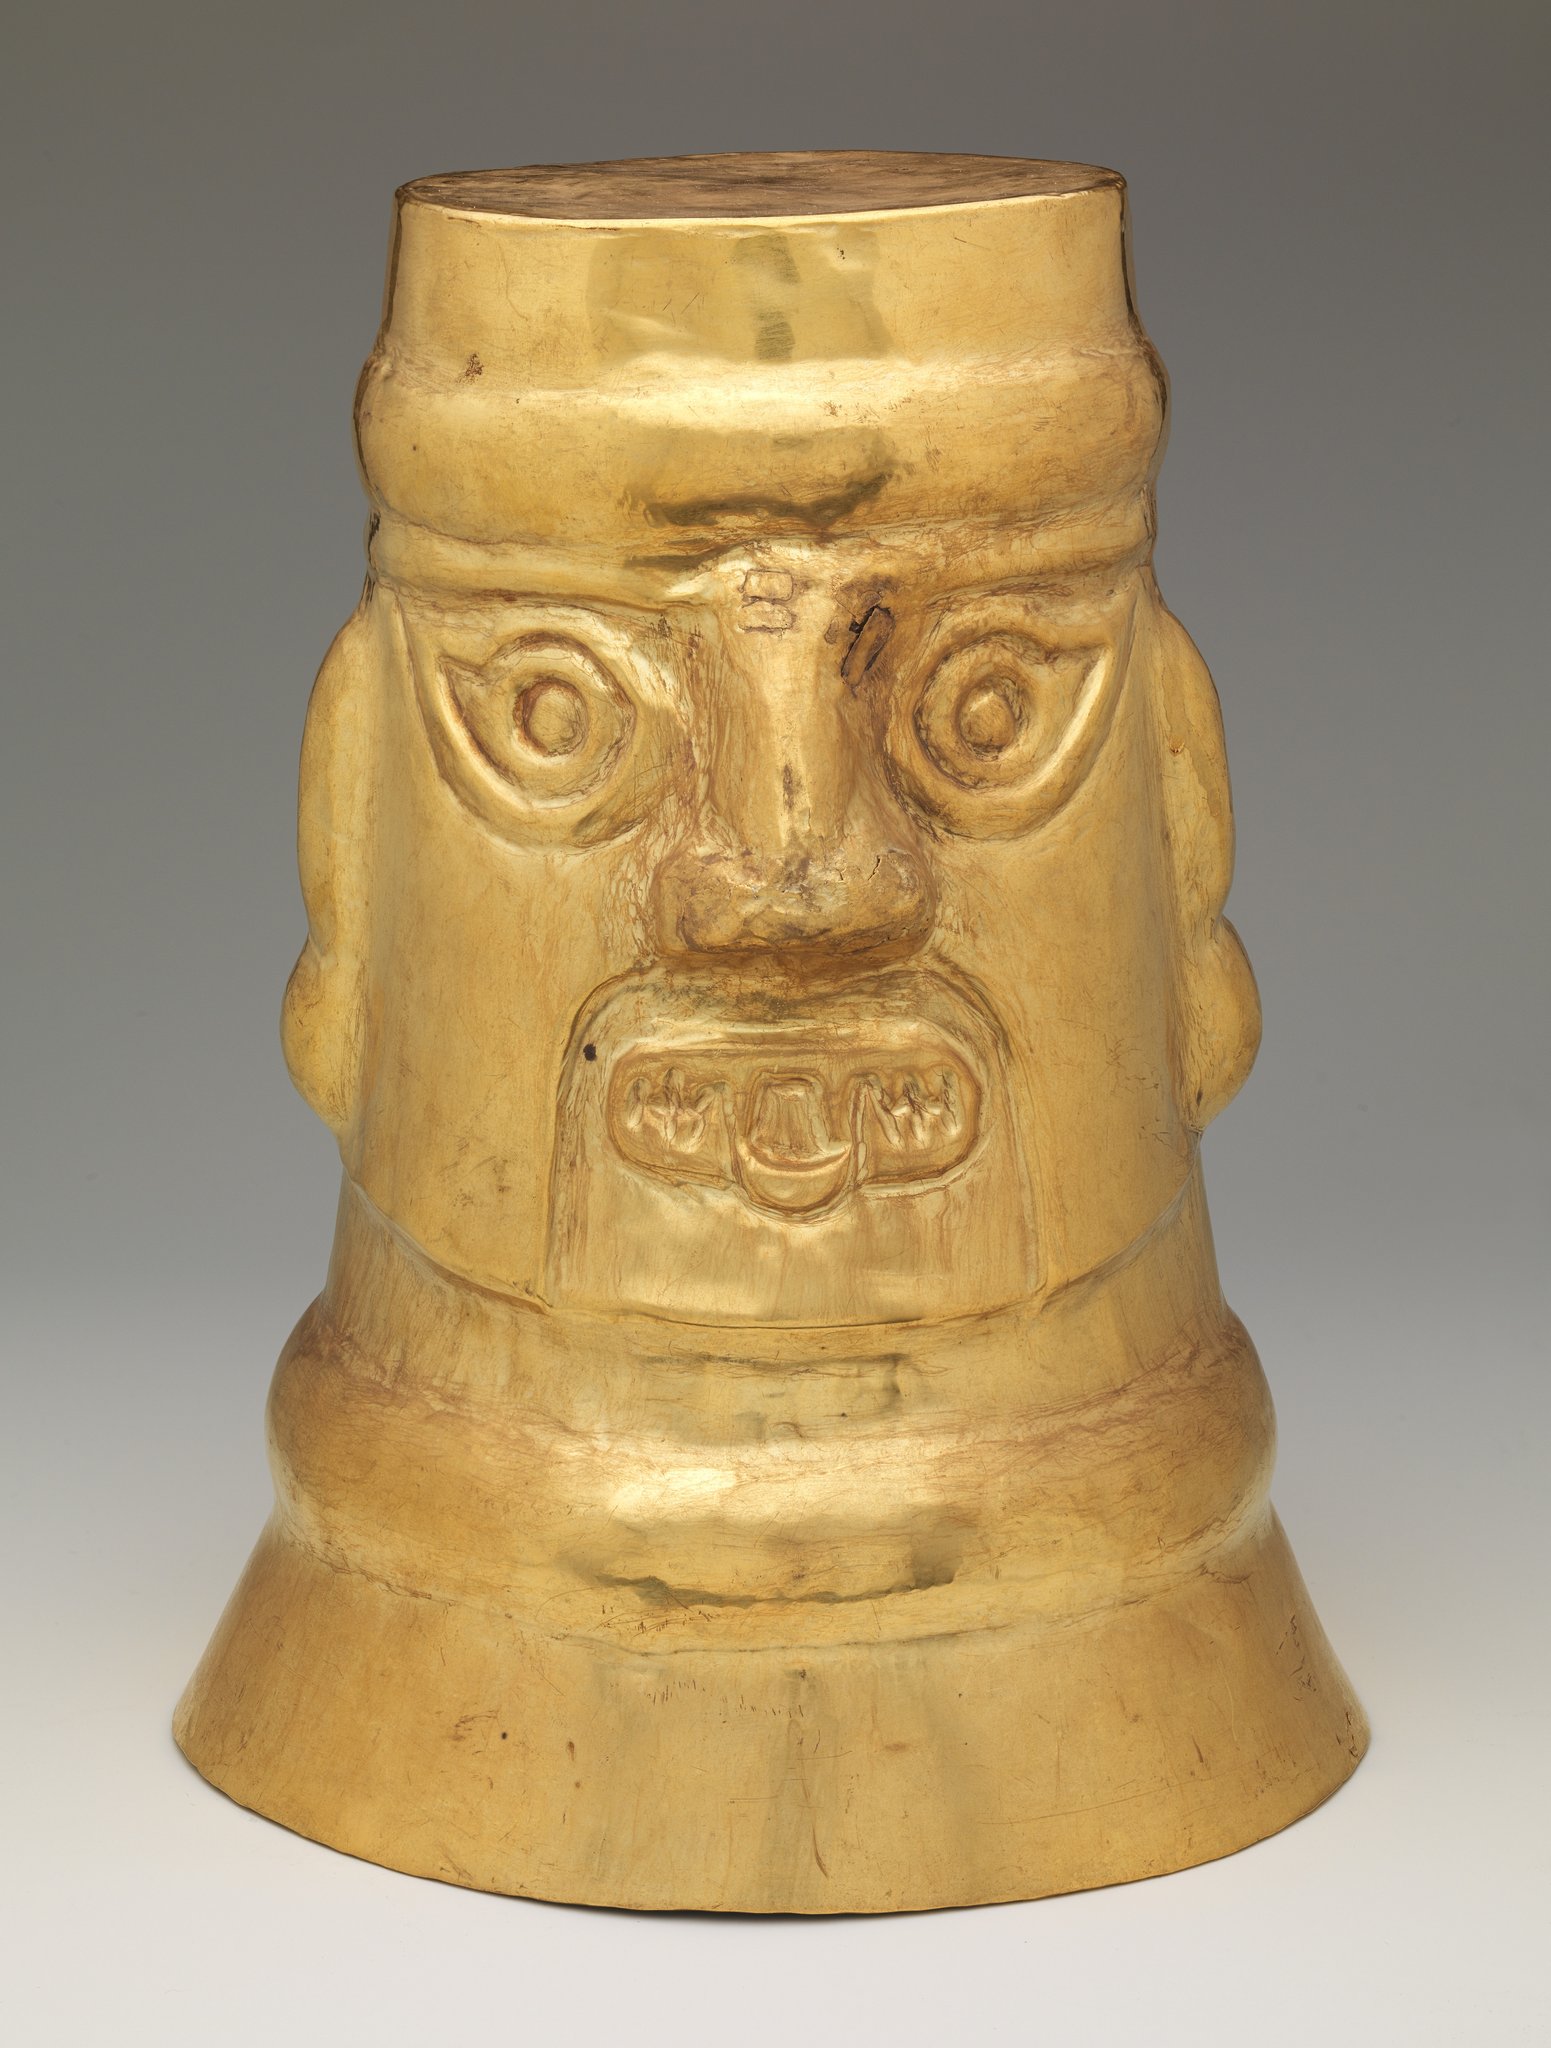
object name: beaker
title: Beaker with inverse face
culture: lambayeque, sicán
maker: lambayeque (sicán) artist(s)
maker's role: artist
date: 900-1100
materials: gold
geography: peru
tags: faces